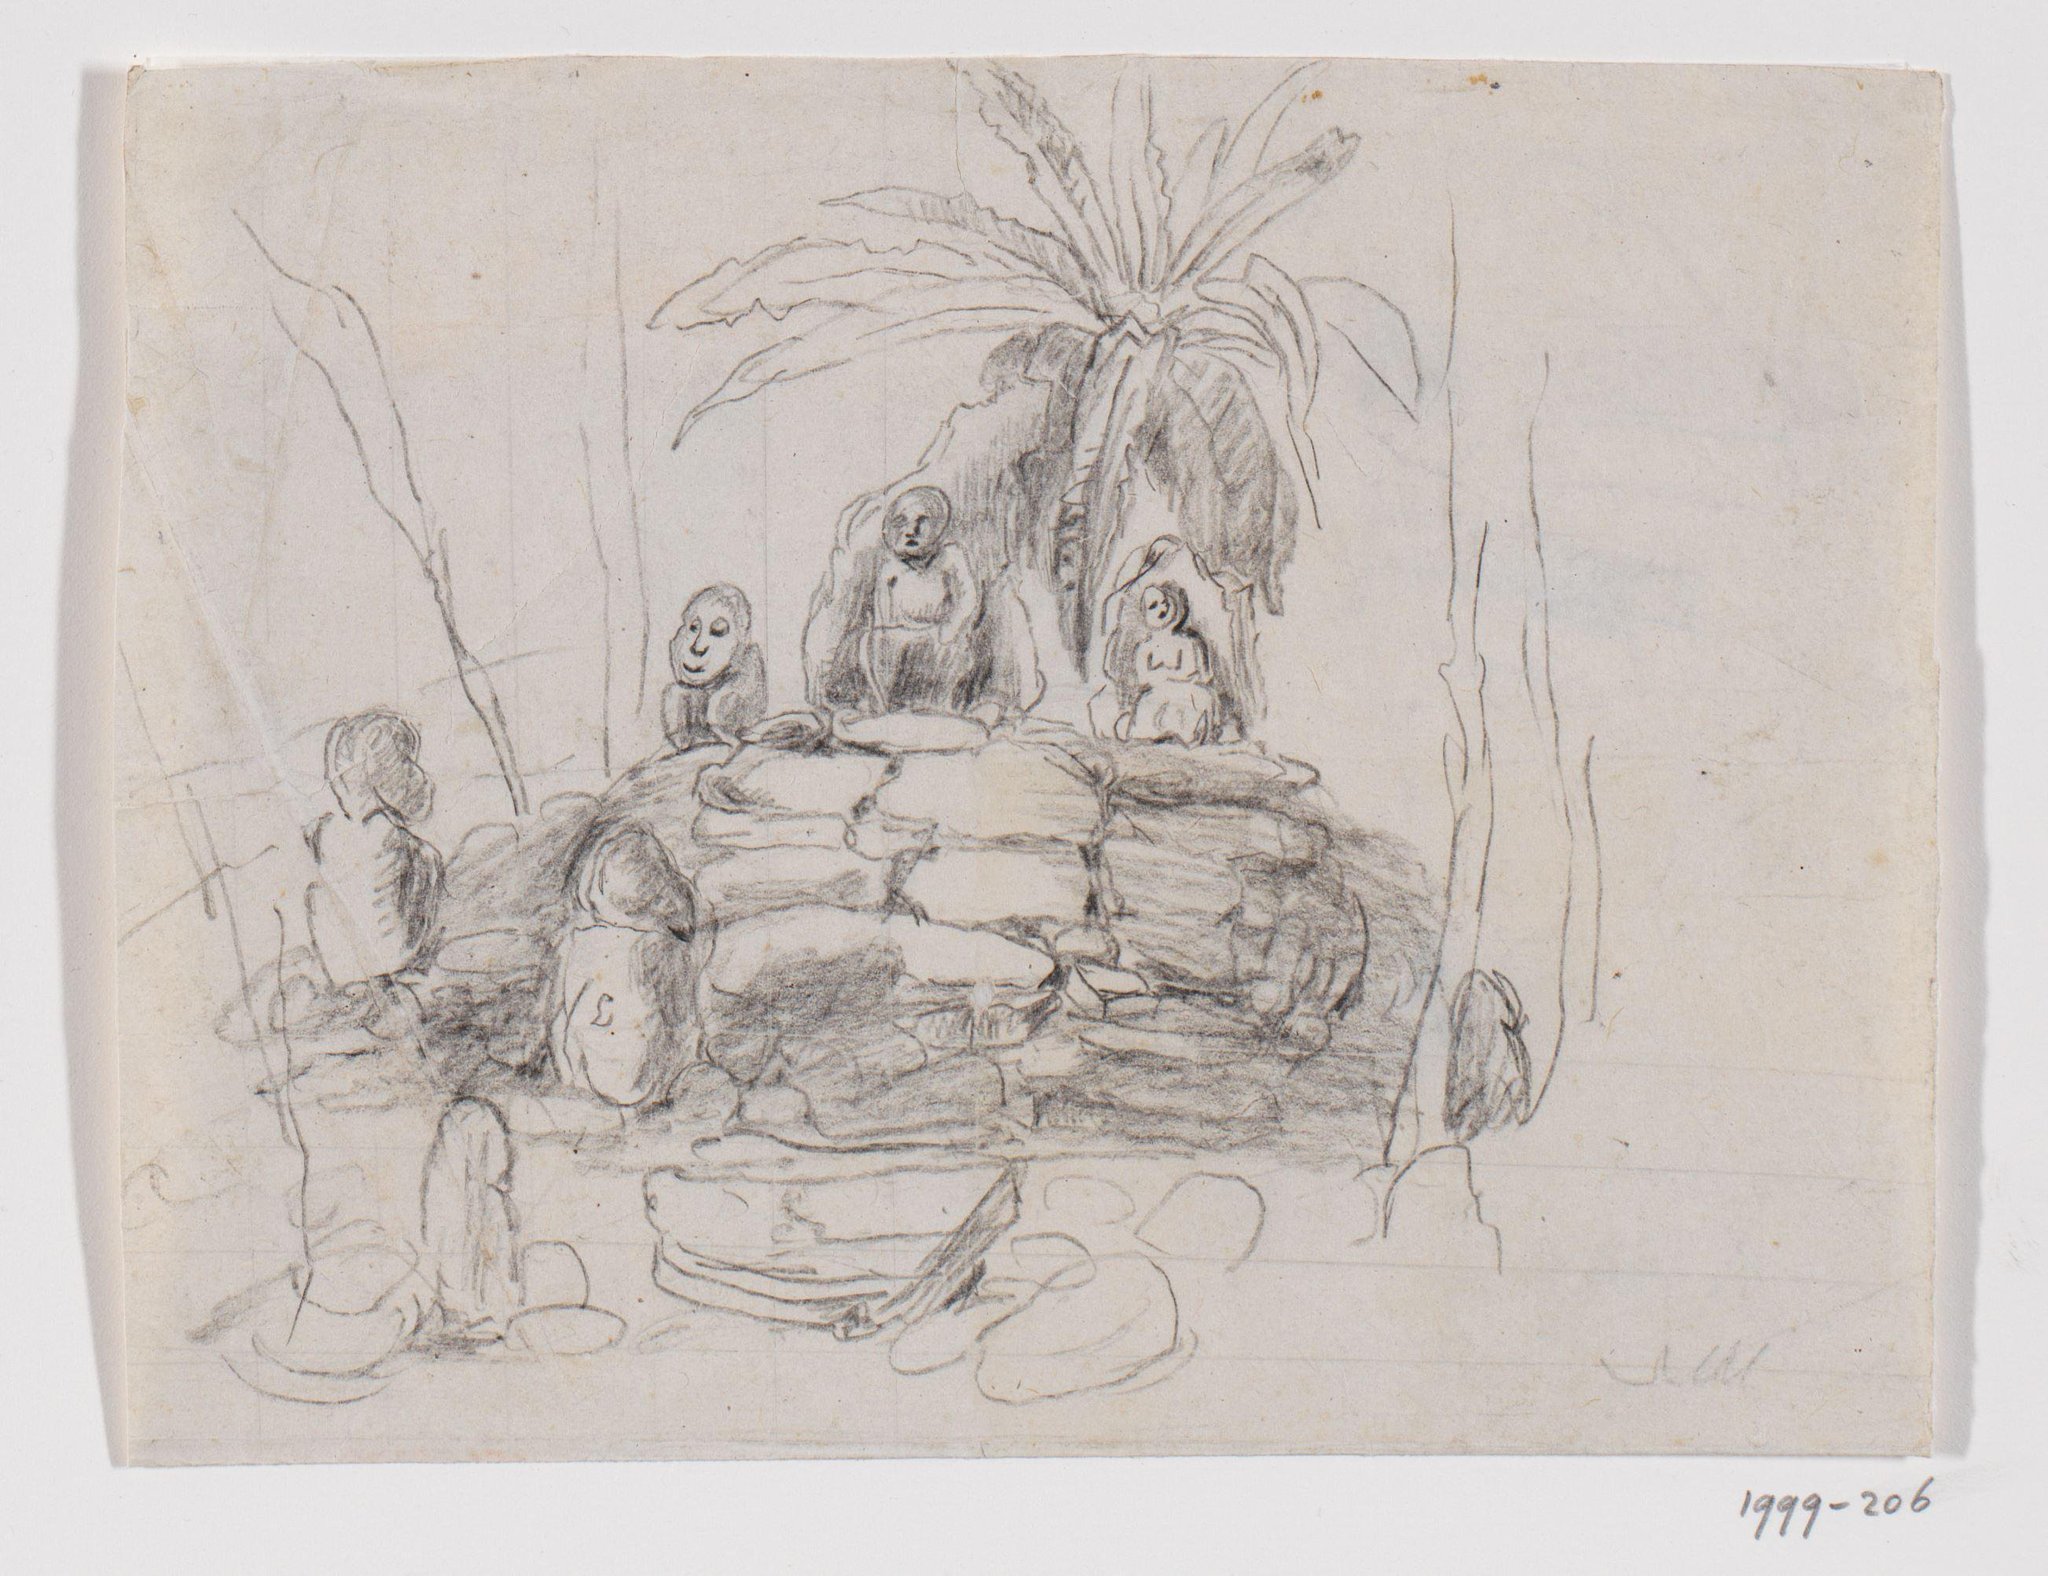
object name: drawing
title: Beeldengroep, Artja [Arca] Domas, bij Buitenzorg (Bogor), West-Java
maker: adrianus johannes bik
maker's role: draughtsman, print maker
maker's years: 1790-1872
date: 1819-1824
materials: chalk, paper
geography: west java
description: zie litho [1] "De Artja Domas, of acht honderd beelden, bij Buitenzorg, door Ch. Rochussen naar A.J. Bik in atlas Javasche Oudheden. artikel over deze collectie in Bulletin van het Rijksmuseum 49 [2001], nr. 4, pp. 342 e.v.